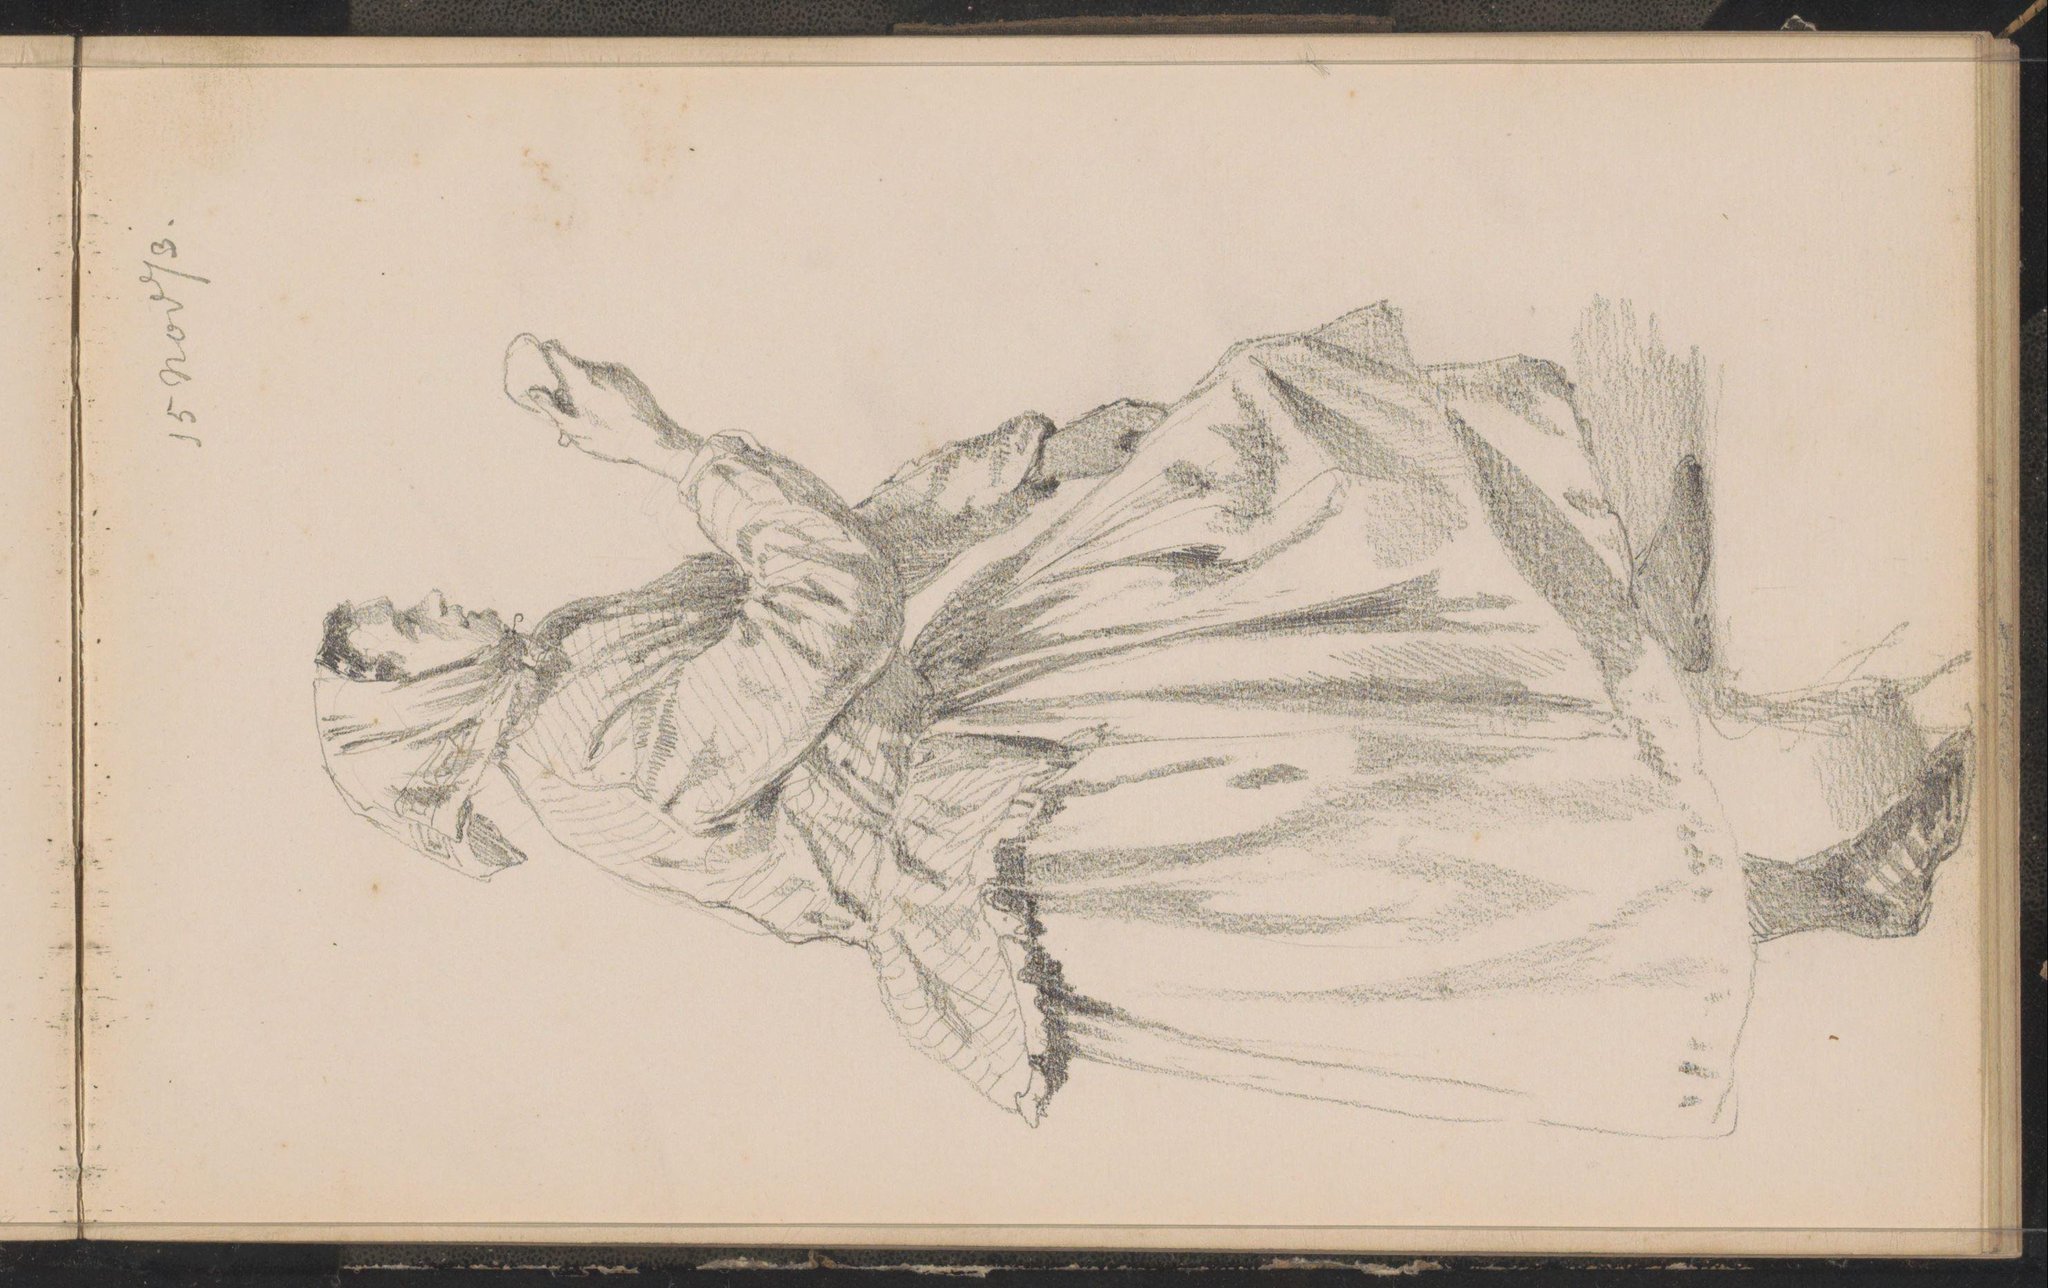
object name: sketchbook leaf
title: Vrouw met een voorwerp, mogelijk een aardappel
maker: cornelis springer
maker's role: draughtsman, painter, print maker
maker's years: 1817-1891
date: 1873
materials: paper, pencil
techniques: stumping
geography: netherlands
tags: standing figure - aa - female human figure (+ sideview, profile), potatoes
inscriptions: date: ‘15 nov 73’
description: Staande vrouw met hoofddoek in profiel naar rechts. Haar linkervoet rust op een verhoging. In haar rechterhand een voorwerp, mogelijk een aardappel. Blad 24 uit een schetsboek met 46 bladen.